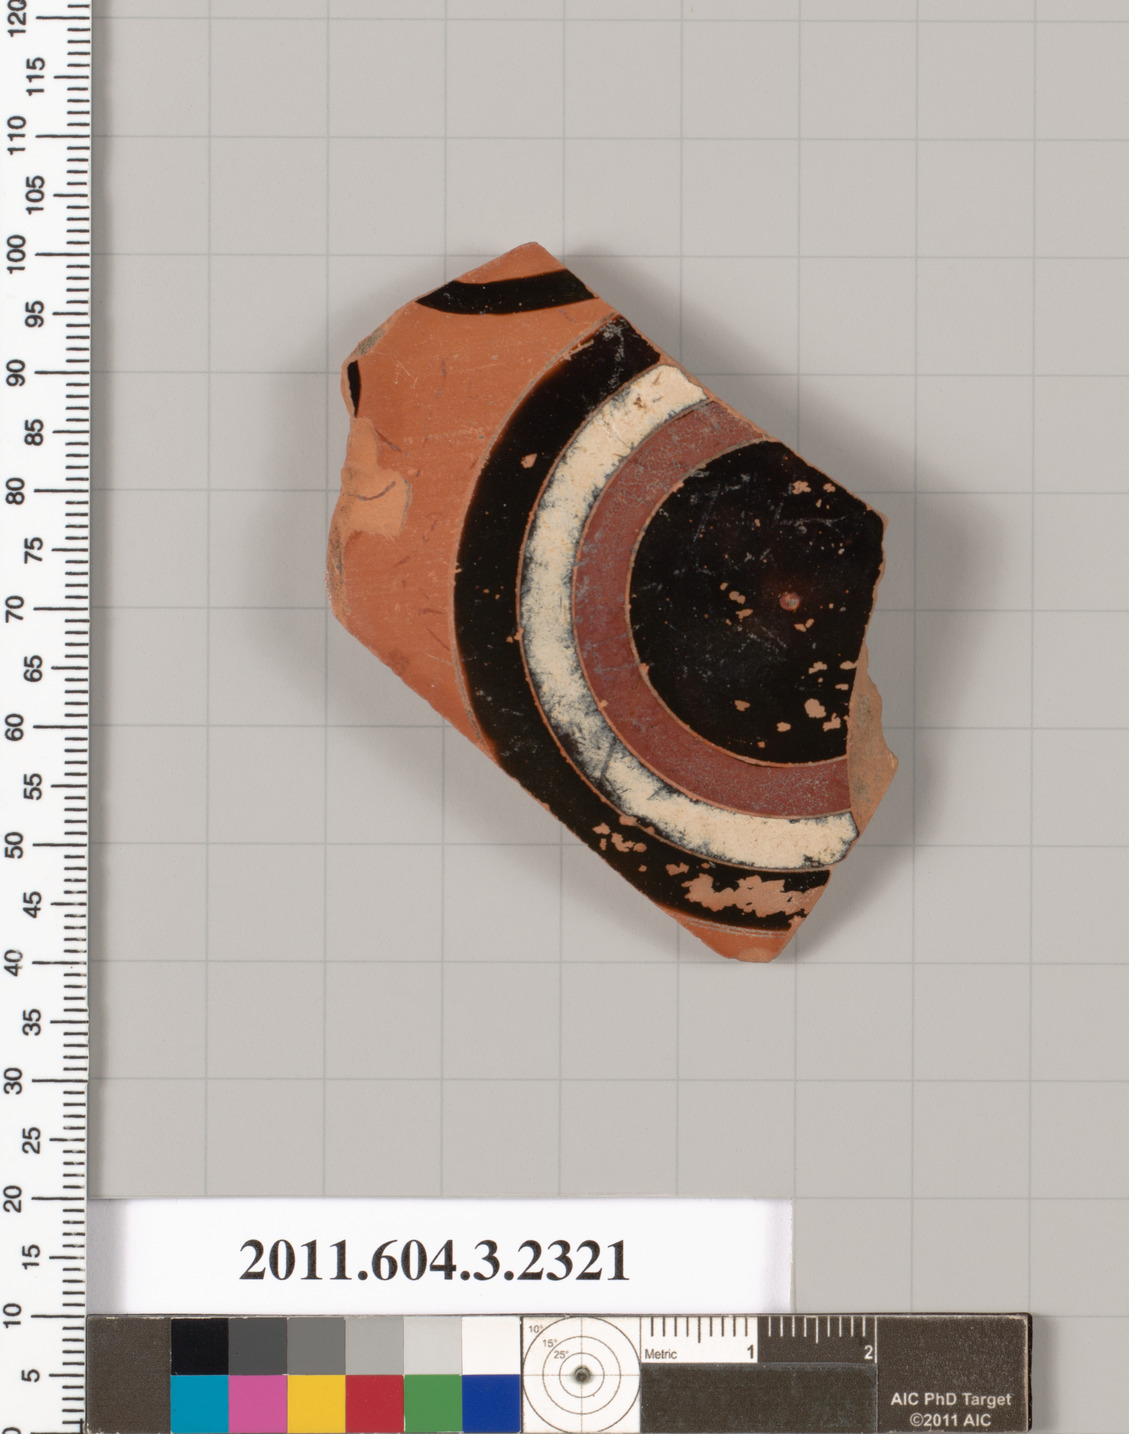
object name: kylix fragment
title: Terracotta fragment of a kylix: eye-cup (drinking cup)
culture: greek, attic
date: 540-520 BCE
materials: terracotta